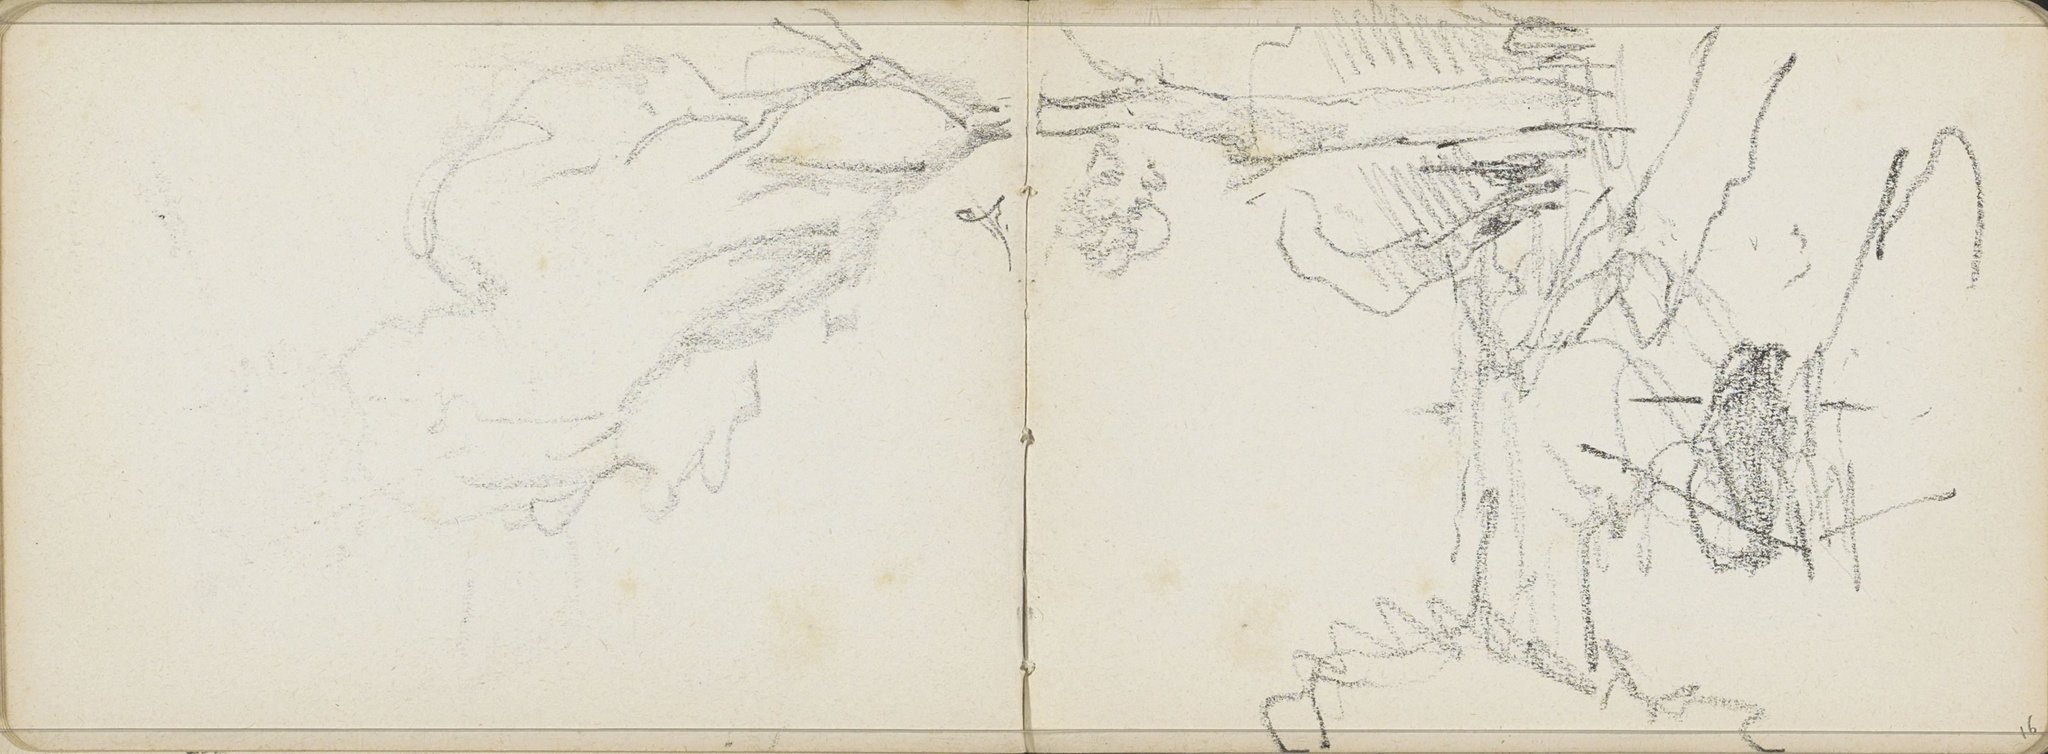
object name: sketchbook leaf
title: Aangemeerde roeiboot aan een waterkant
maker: willem cornelis rip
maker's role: draughtsman, painter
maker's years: 1856-1922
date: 1866-1922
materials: chalk, paper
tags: landscapes with waters, waterscapes, seascapes (in the temperate zone), rowing-boat, canoe, etc.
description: Blad 15 verso en 16 recto uit een schetsboek met 42 bladen.